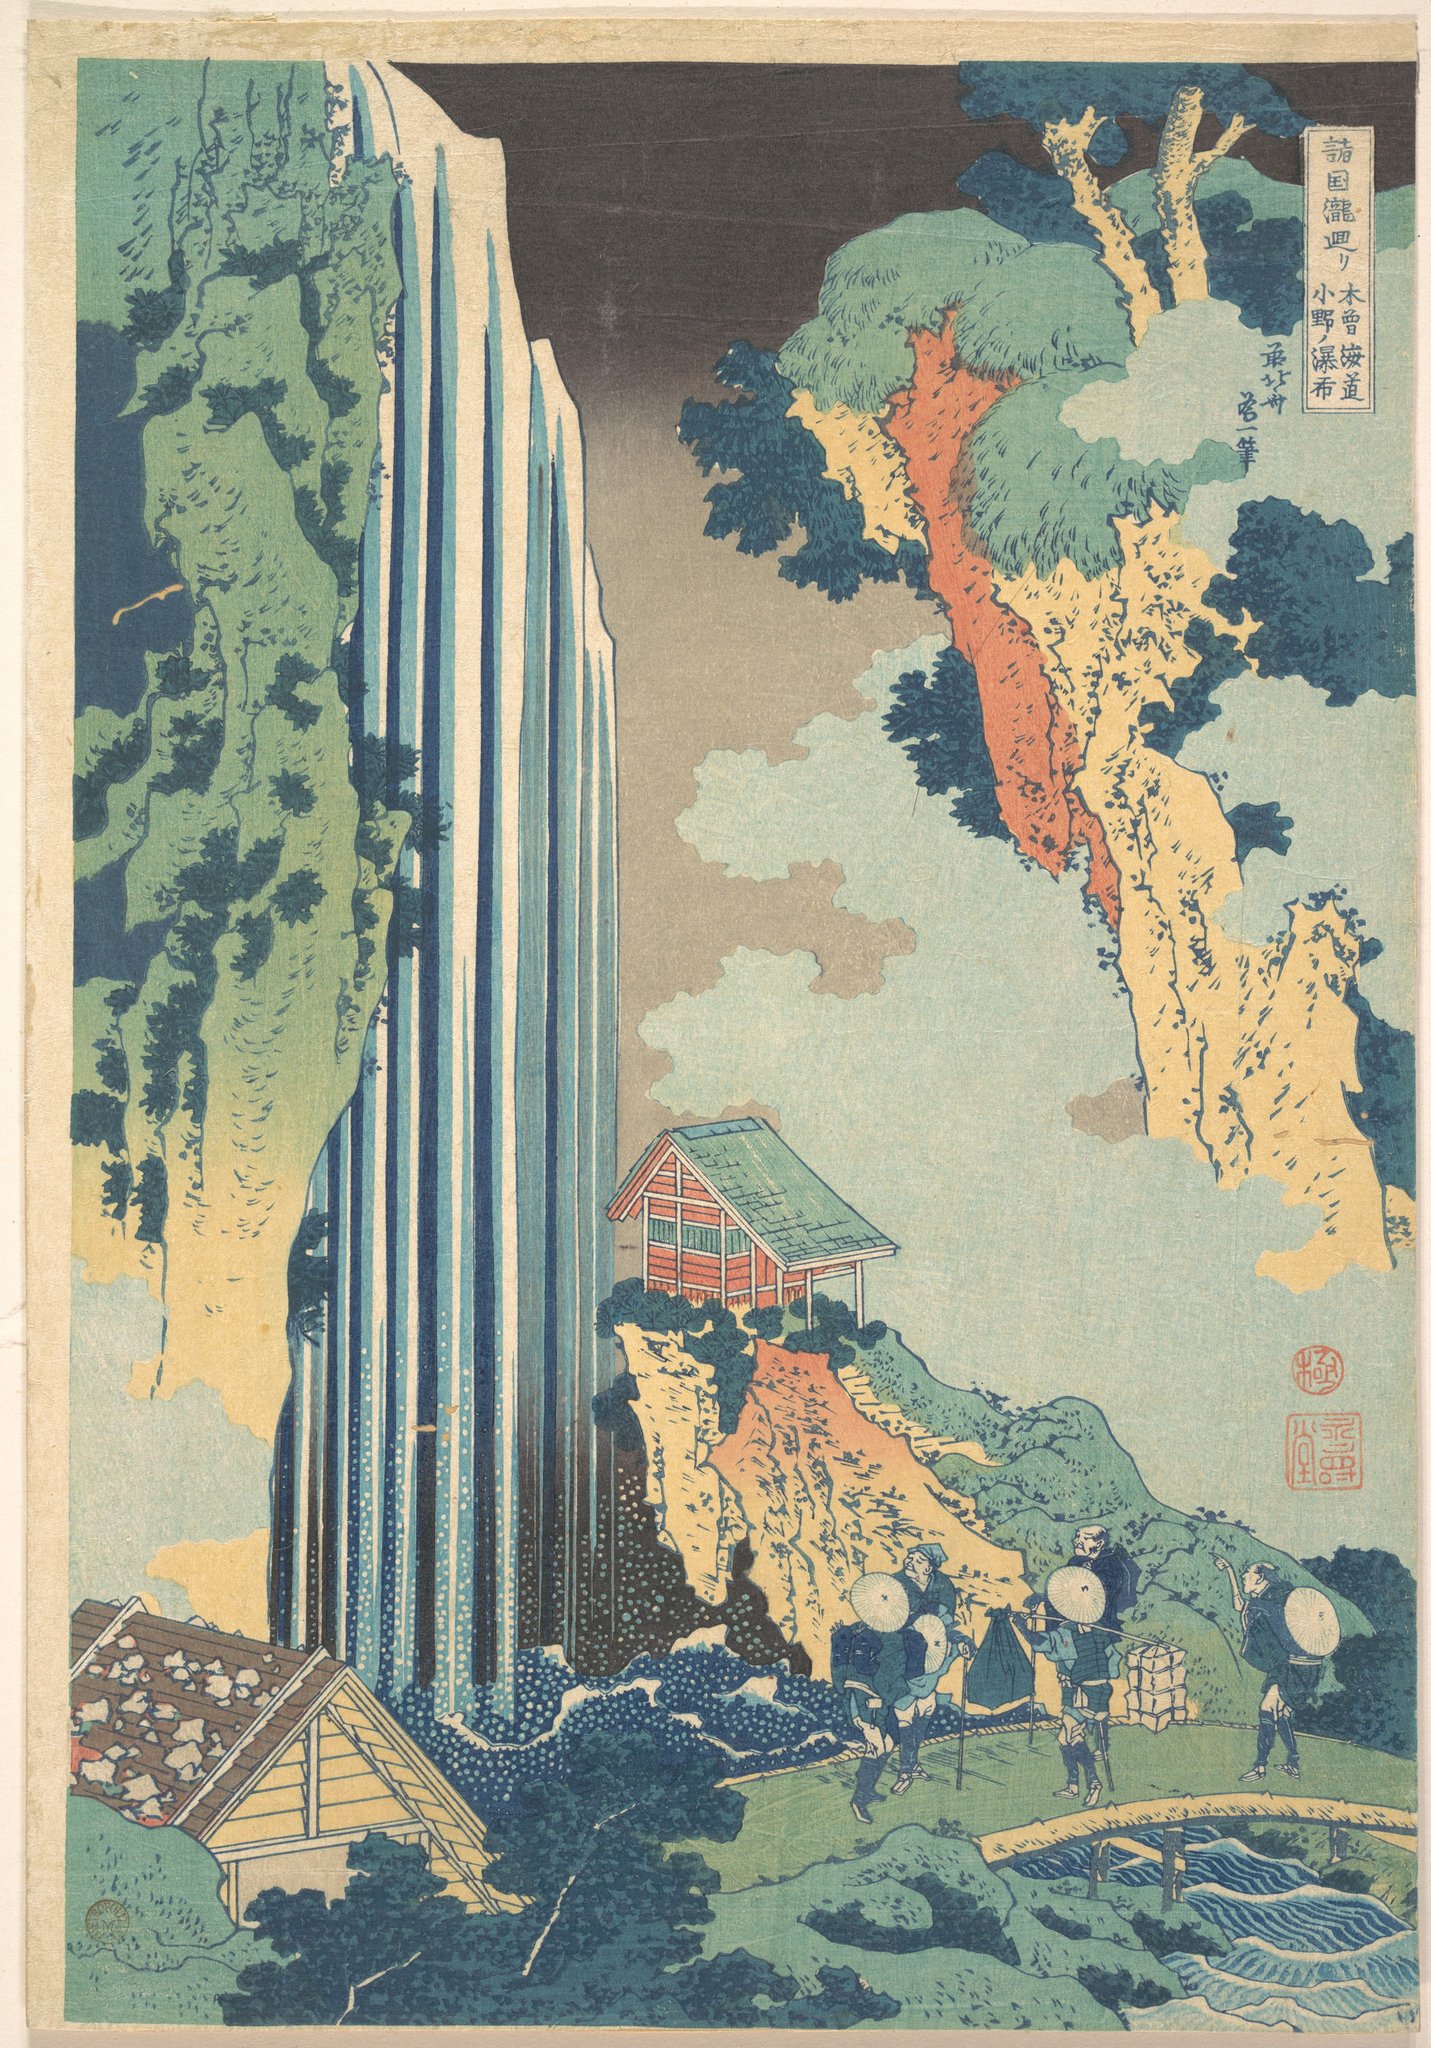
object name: woodblock print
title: Ono Waterfall on the Kisokaidō (Kisokaidō Ono no bakufu), from the series A Tour of Waterfalls in Various Provinces (Shokoku taki meguri)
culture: japanese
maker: katsushika hokusai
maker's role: artist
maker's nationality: japanese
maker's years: 1760-1849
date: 1832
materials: ink, paper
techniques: woodblock print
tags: houses,men,waterfalls,trees